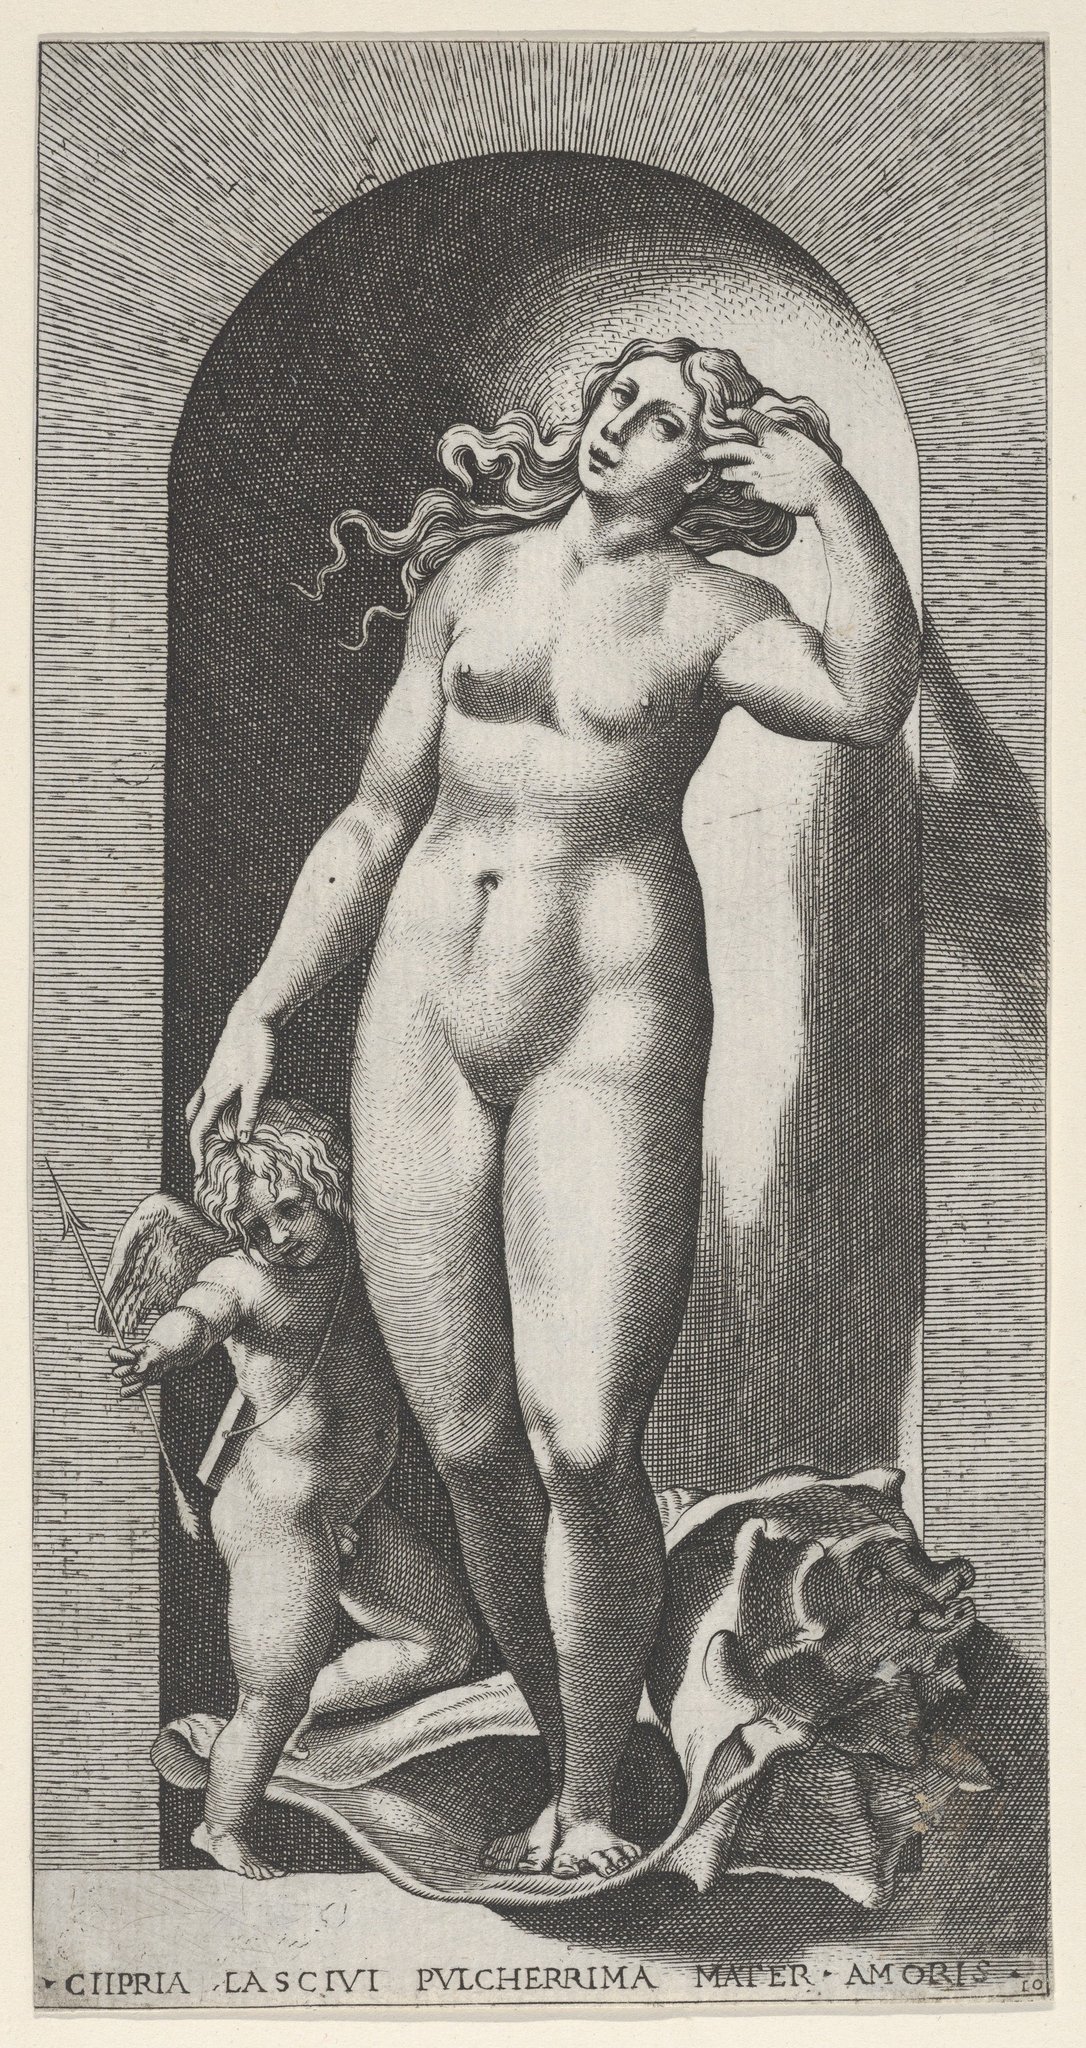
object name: print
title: Plate 10: Venus in a niche, standing on a conch shell, with Cupid to her right, from "Mythological Gods and Goddesses"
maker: giovanni jacopo caraglio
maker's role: artist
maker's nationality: italian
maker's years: 1500-1565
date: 1526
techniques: engraving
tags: cupid,venus,shells